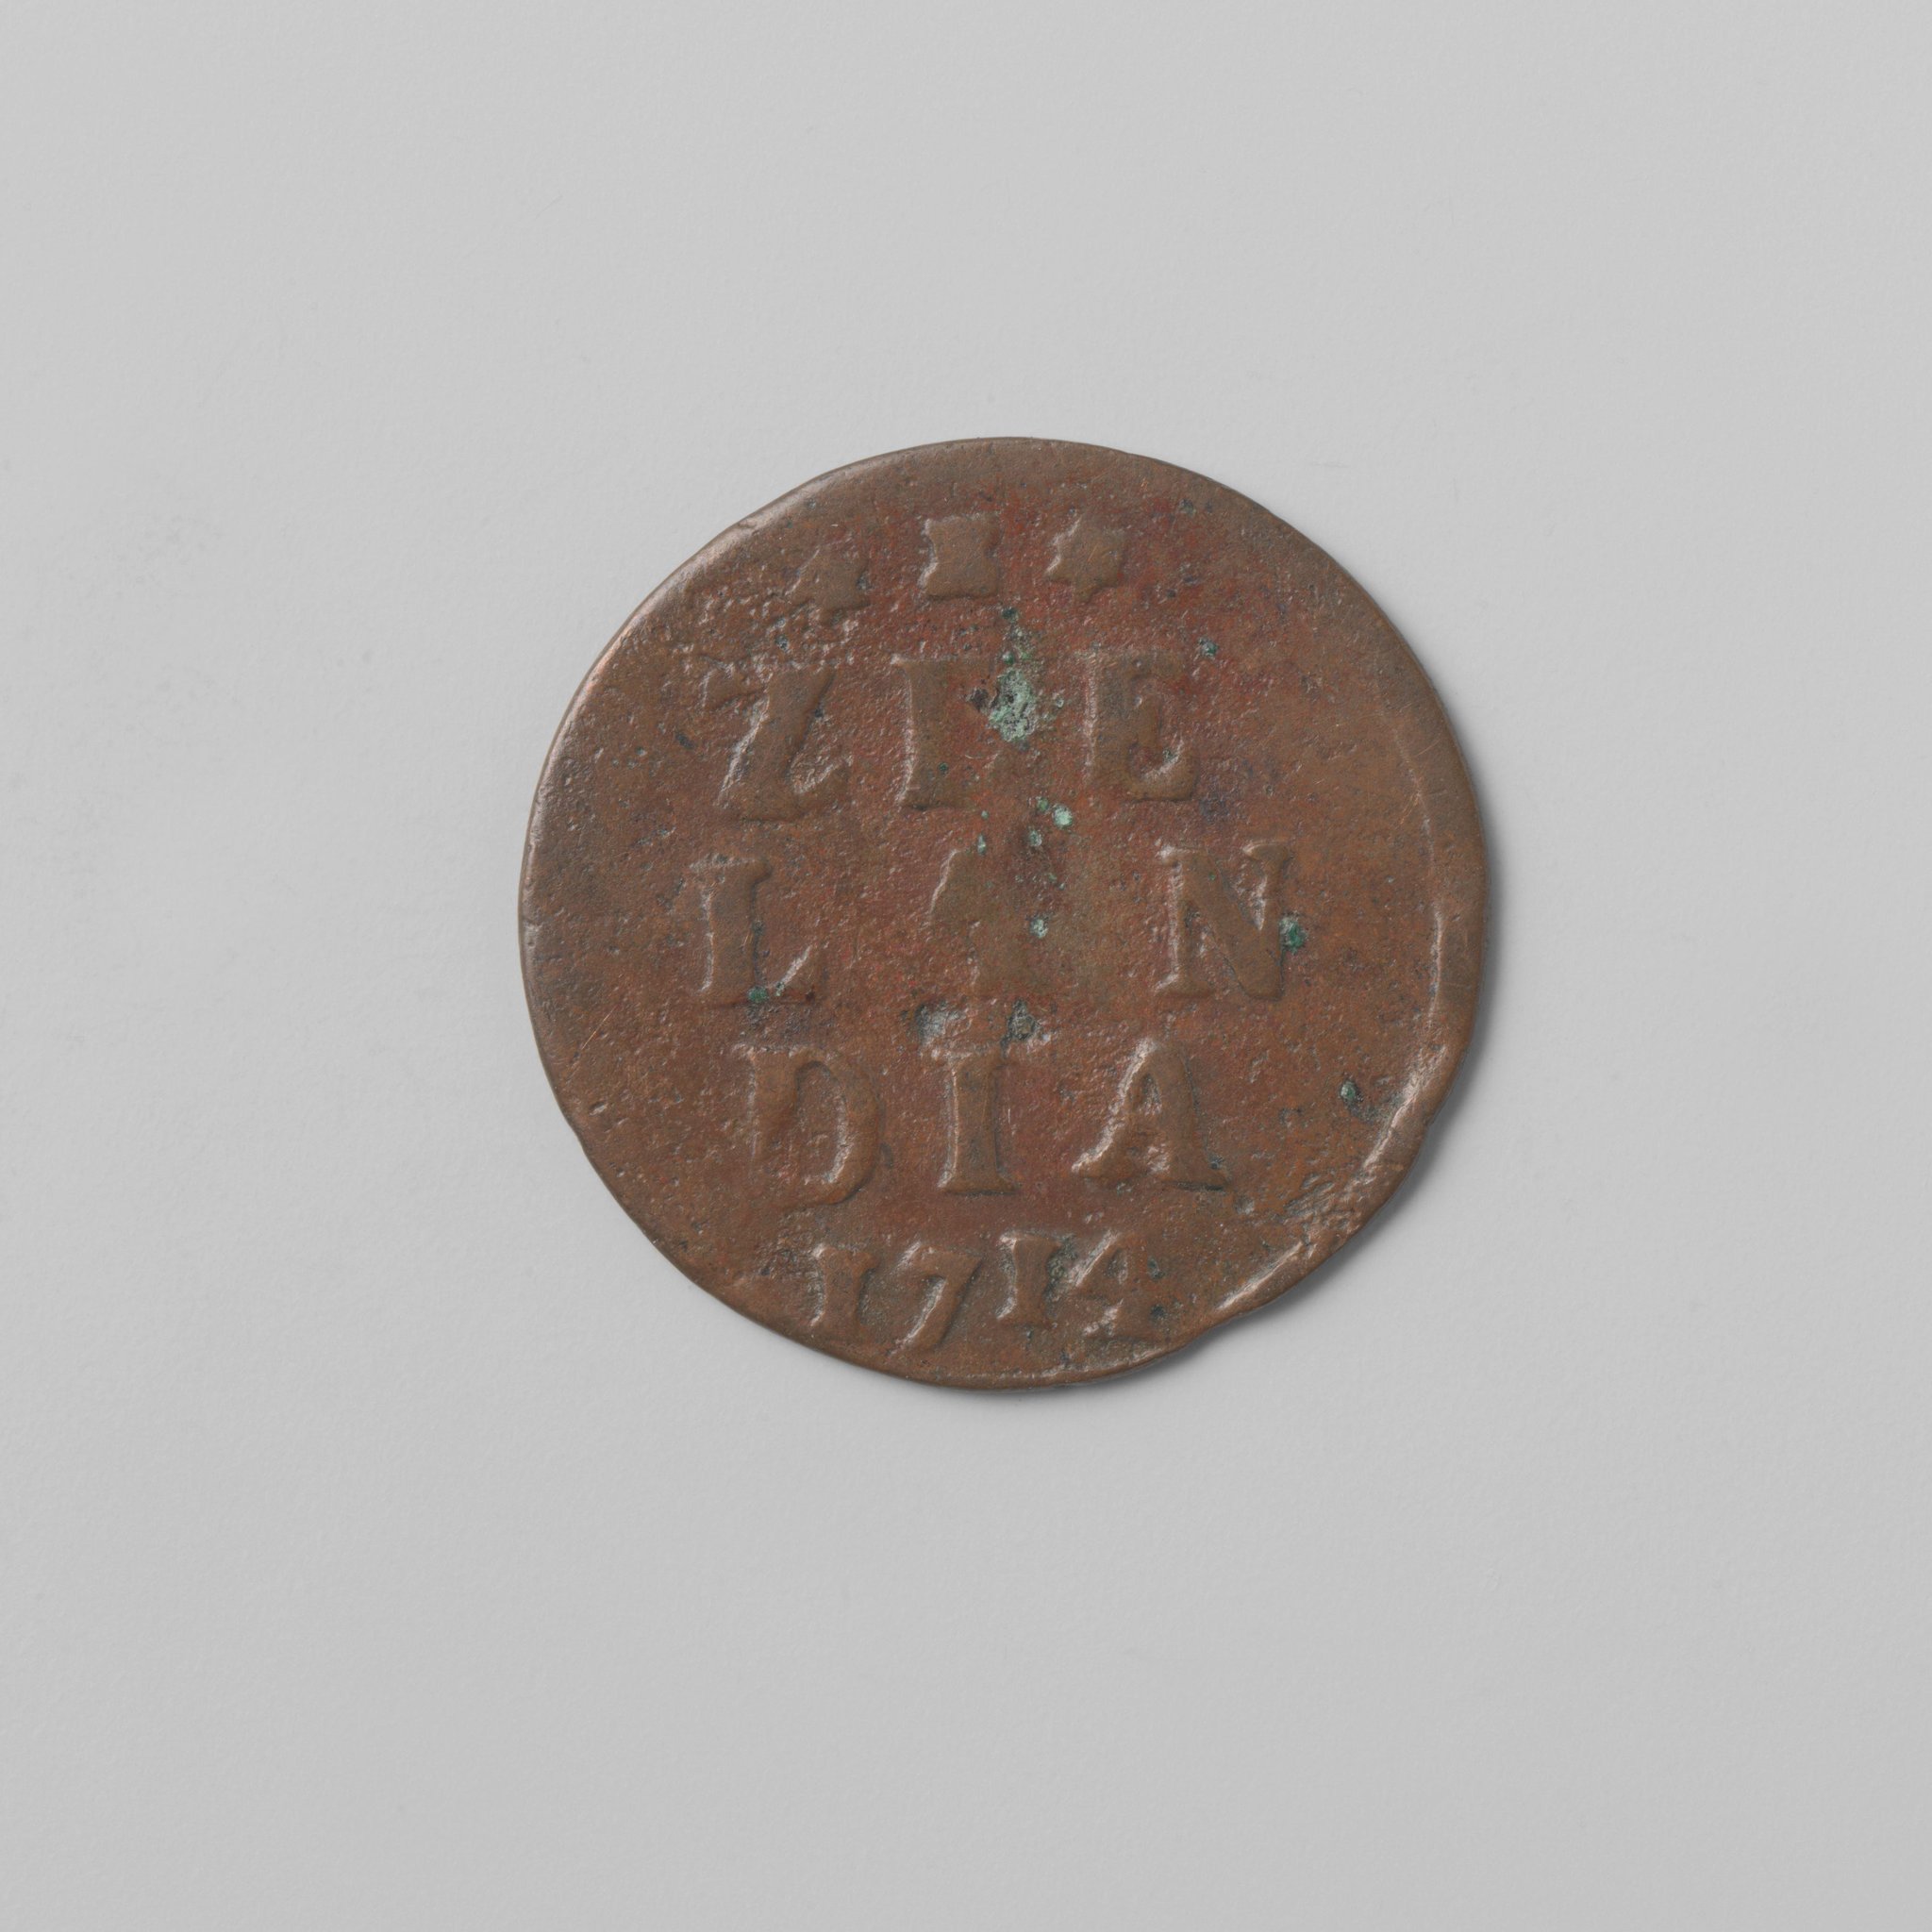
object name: coin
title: Zeeland, duit, 1714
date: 1714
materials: copper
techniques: striking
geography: middelburg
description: Koperen munt. Voorzijde: wapen van Zeeland. Keerzijde: opschrift in drie regels, waarboven muntteken burcht tussen twee sterren en waaronder jaartal.